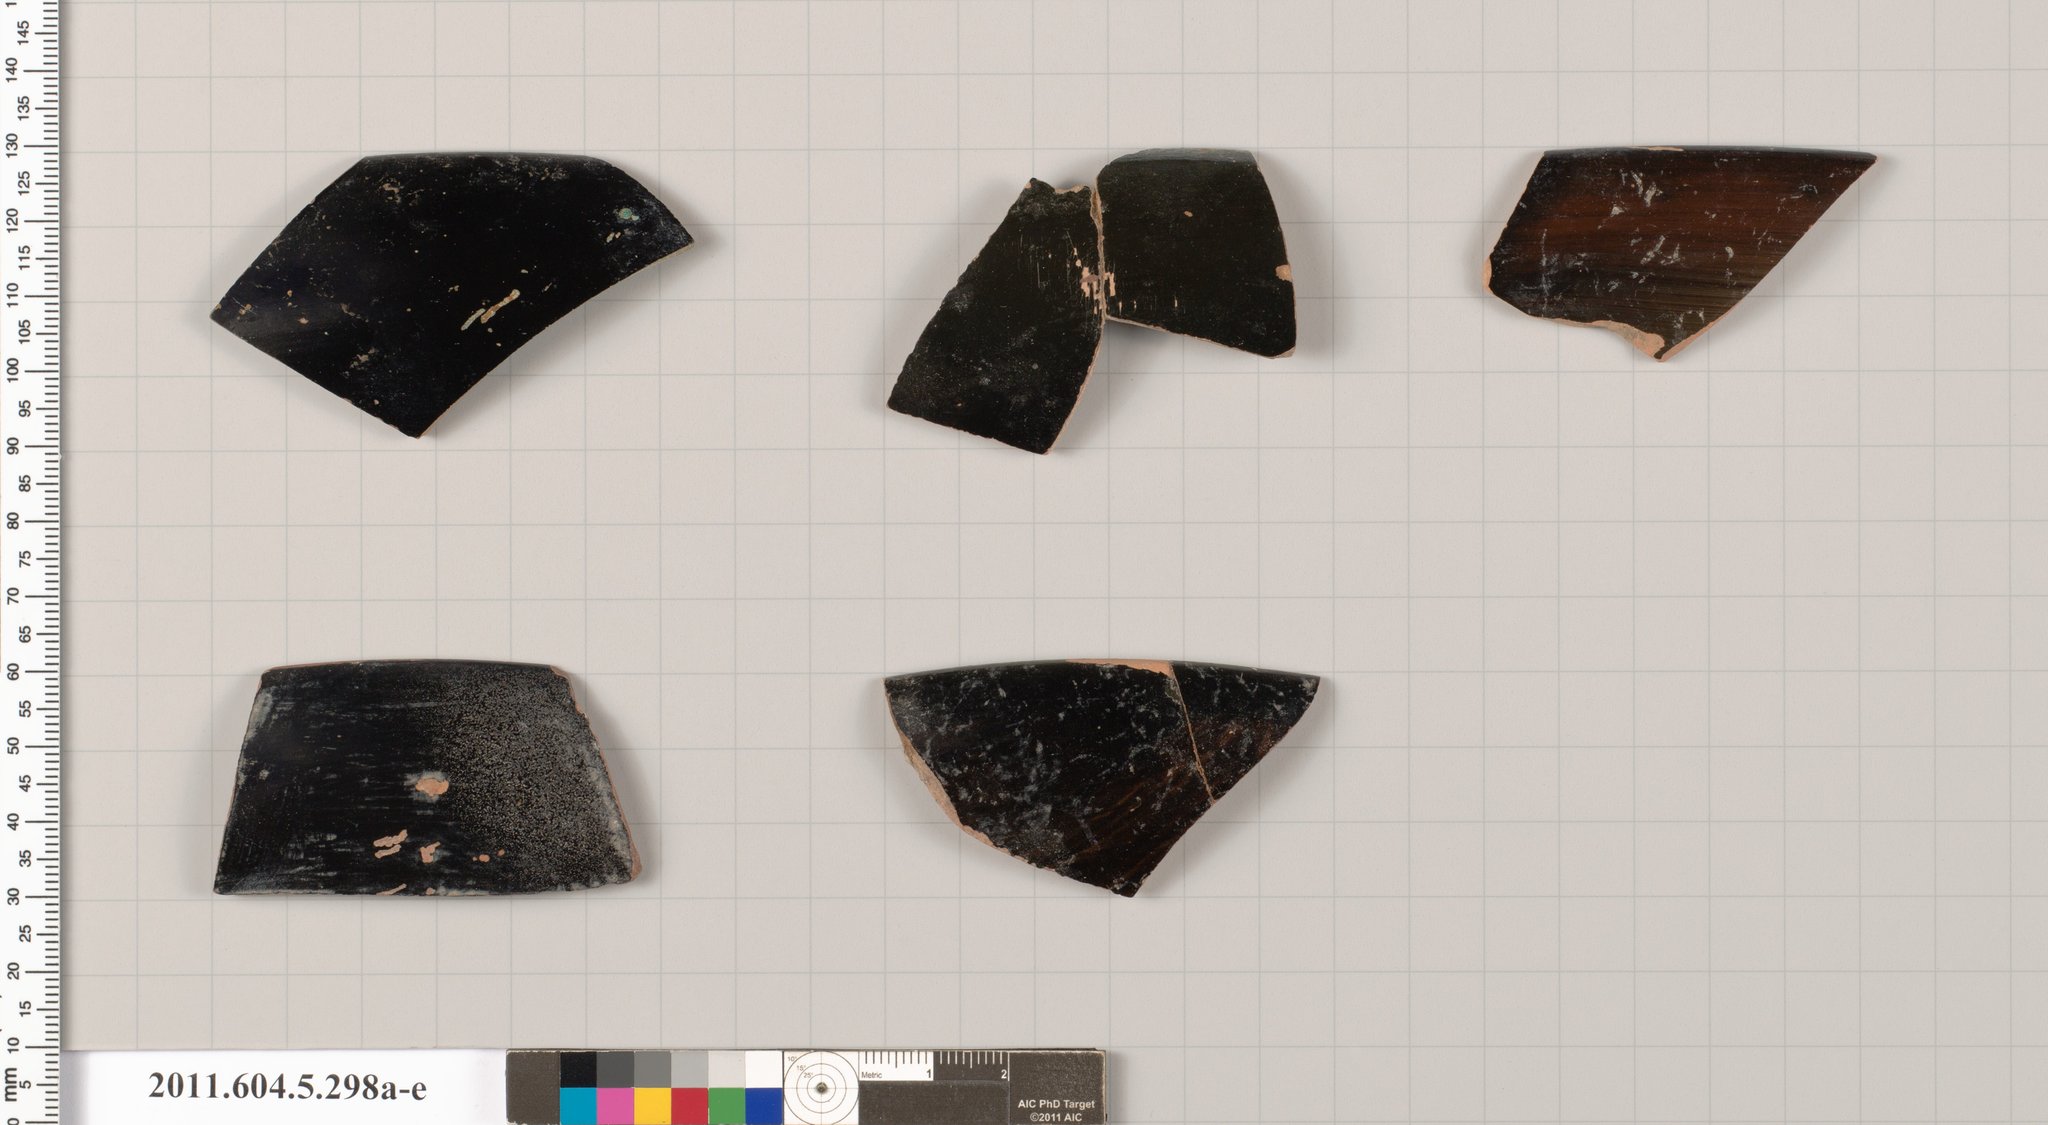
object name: kylix fragment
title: Terracotta rim fragments of kylikes (drinking cups)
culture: greek, attic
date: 600-401 BCE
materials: terracotta